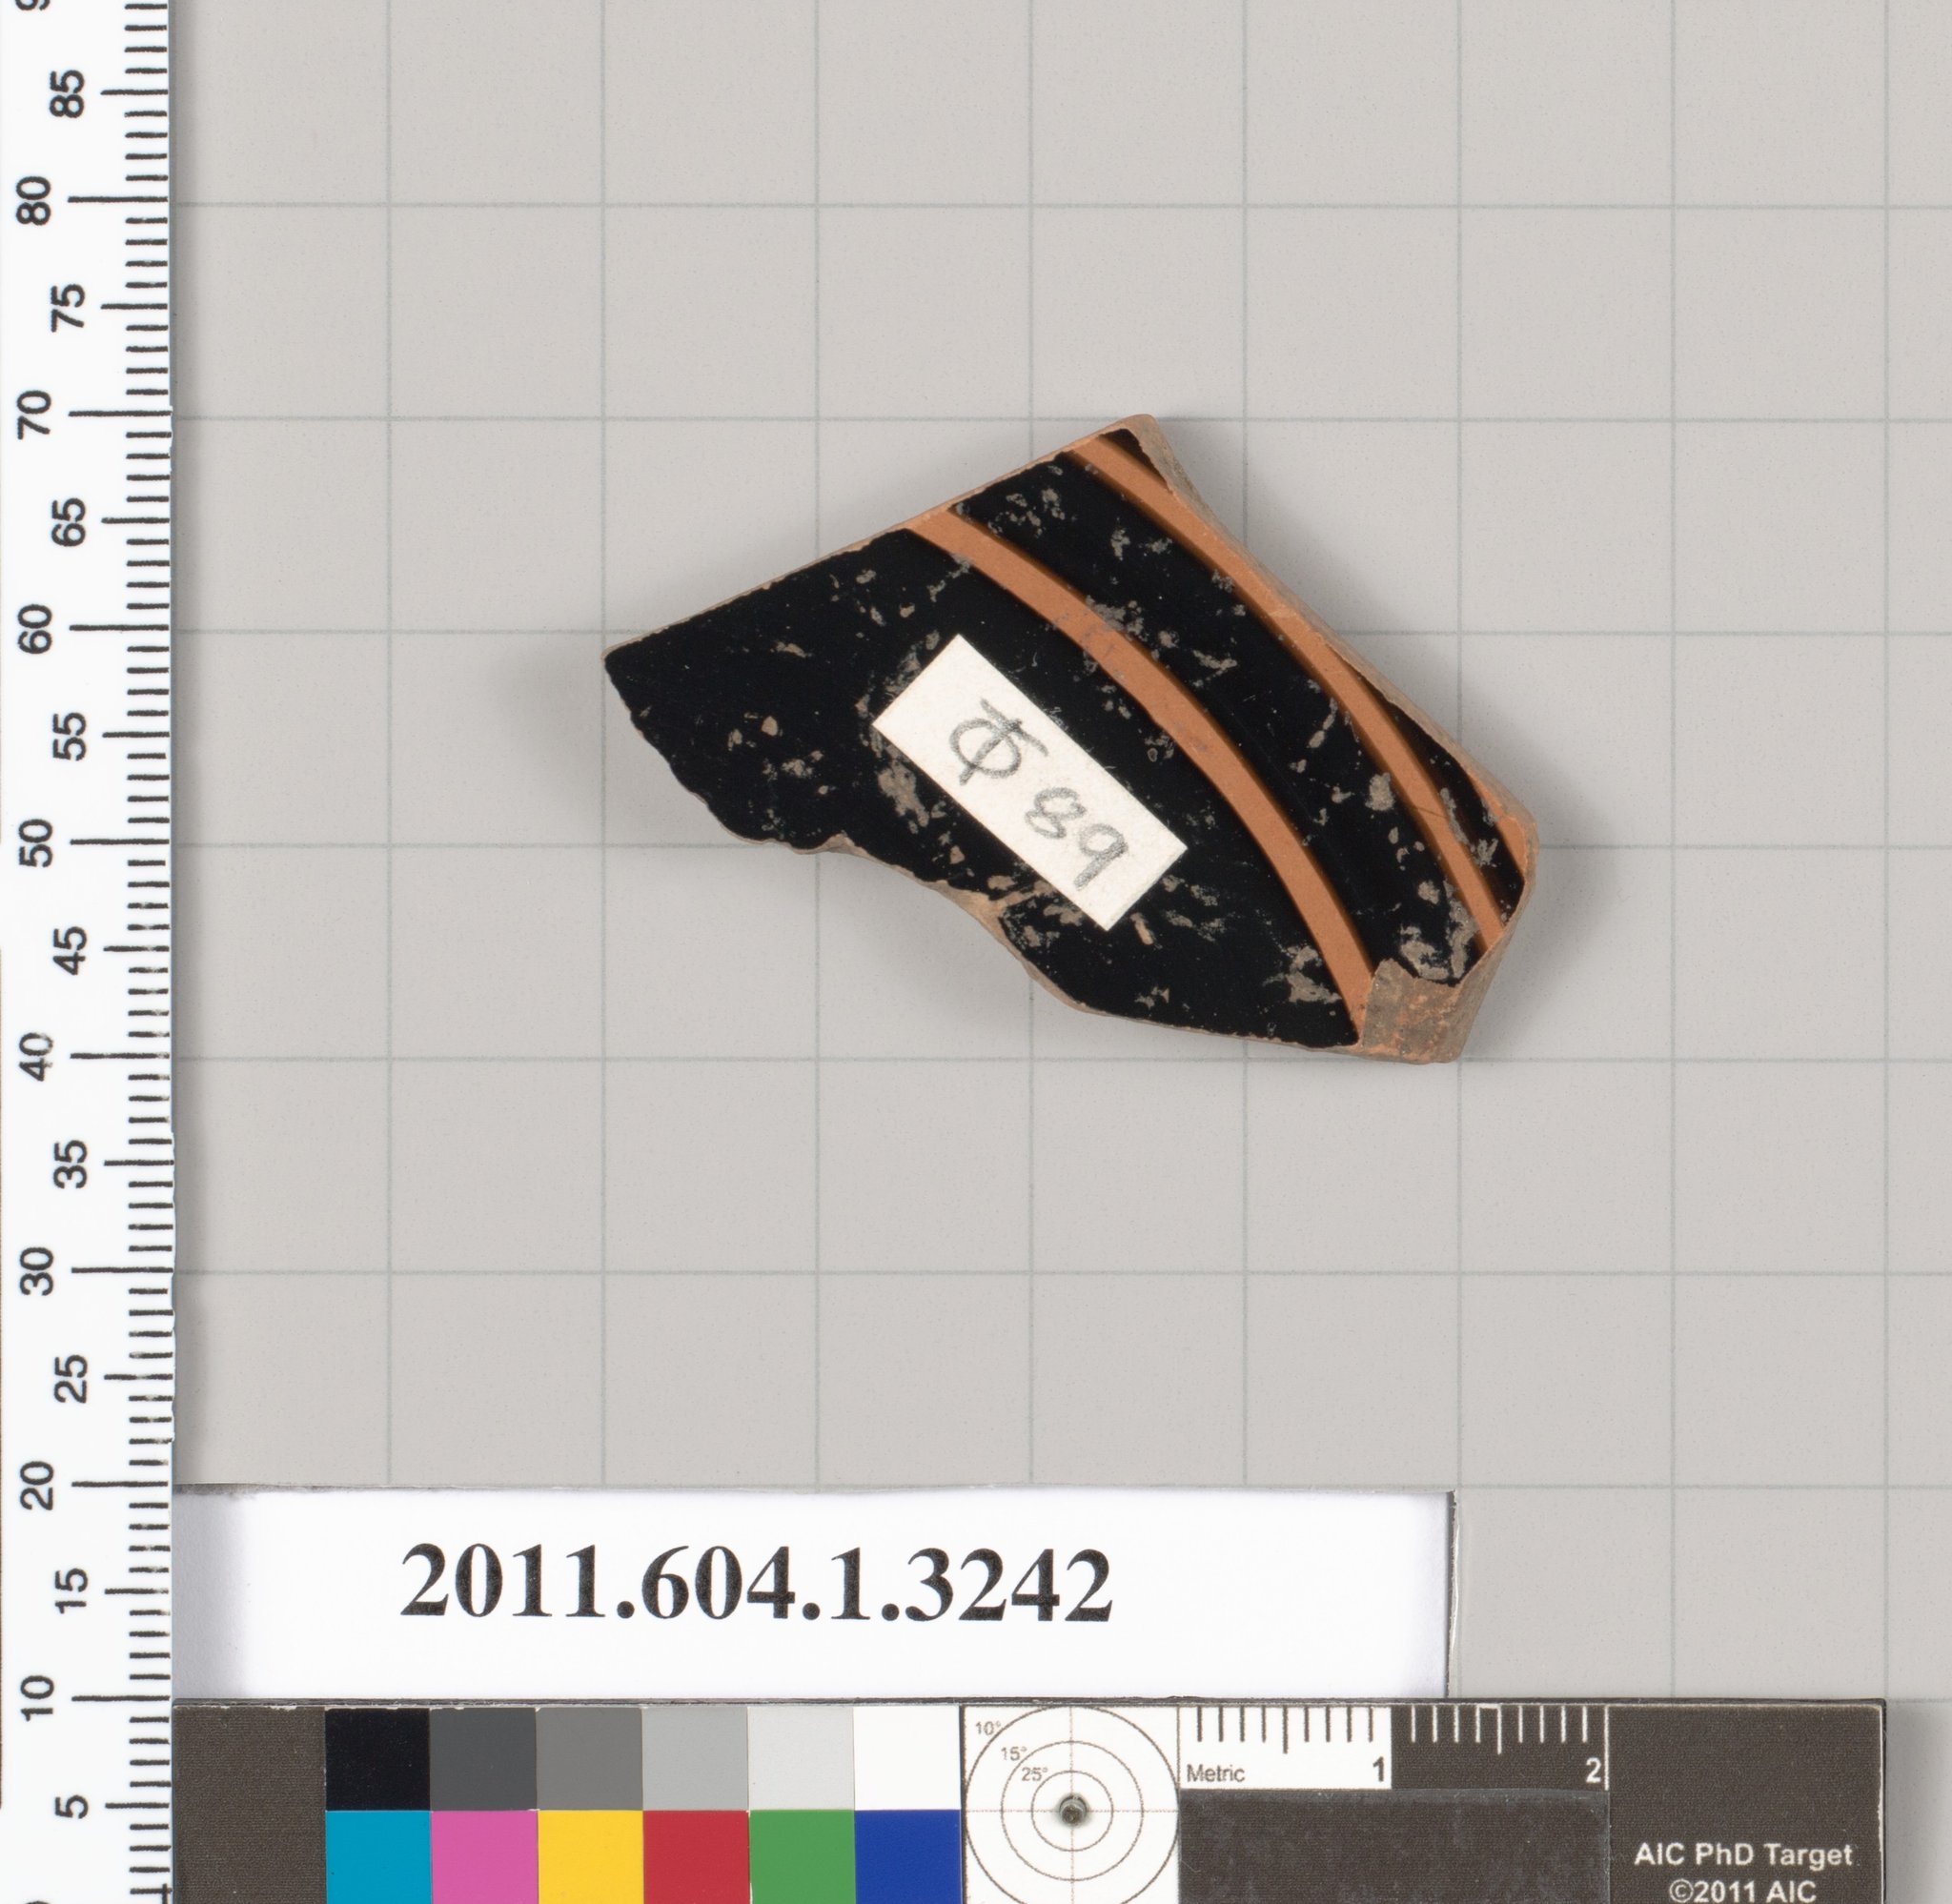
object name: kylix fragment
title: Terracotta fragment of a kylix (drinking cup)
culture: greek, attic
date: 475-451 BCE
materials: terracotta